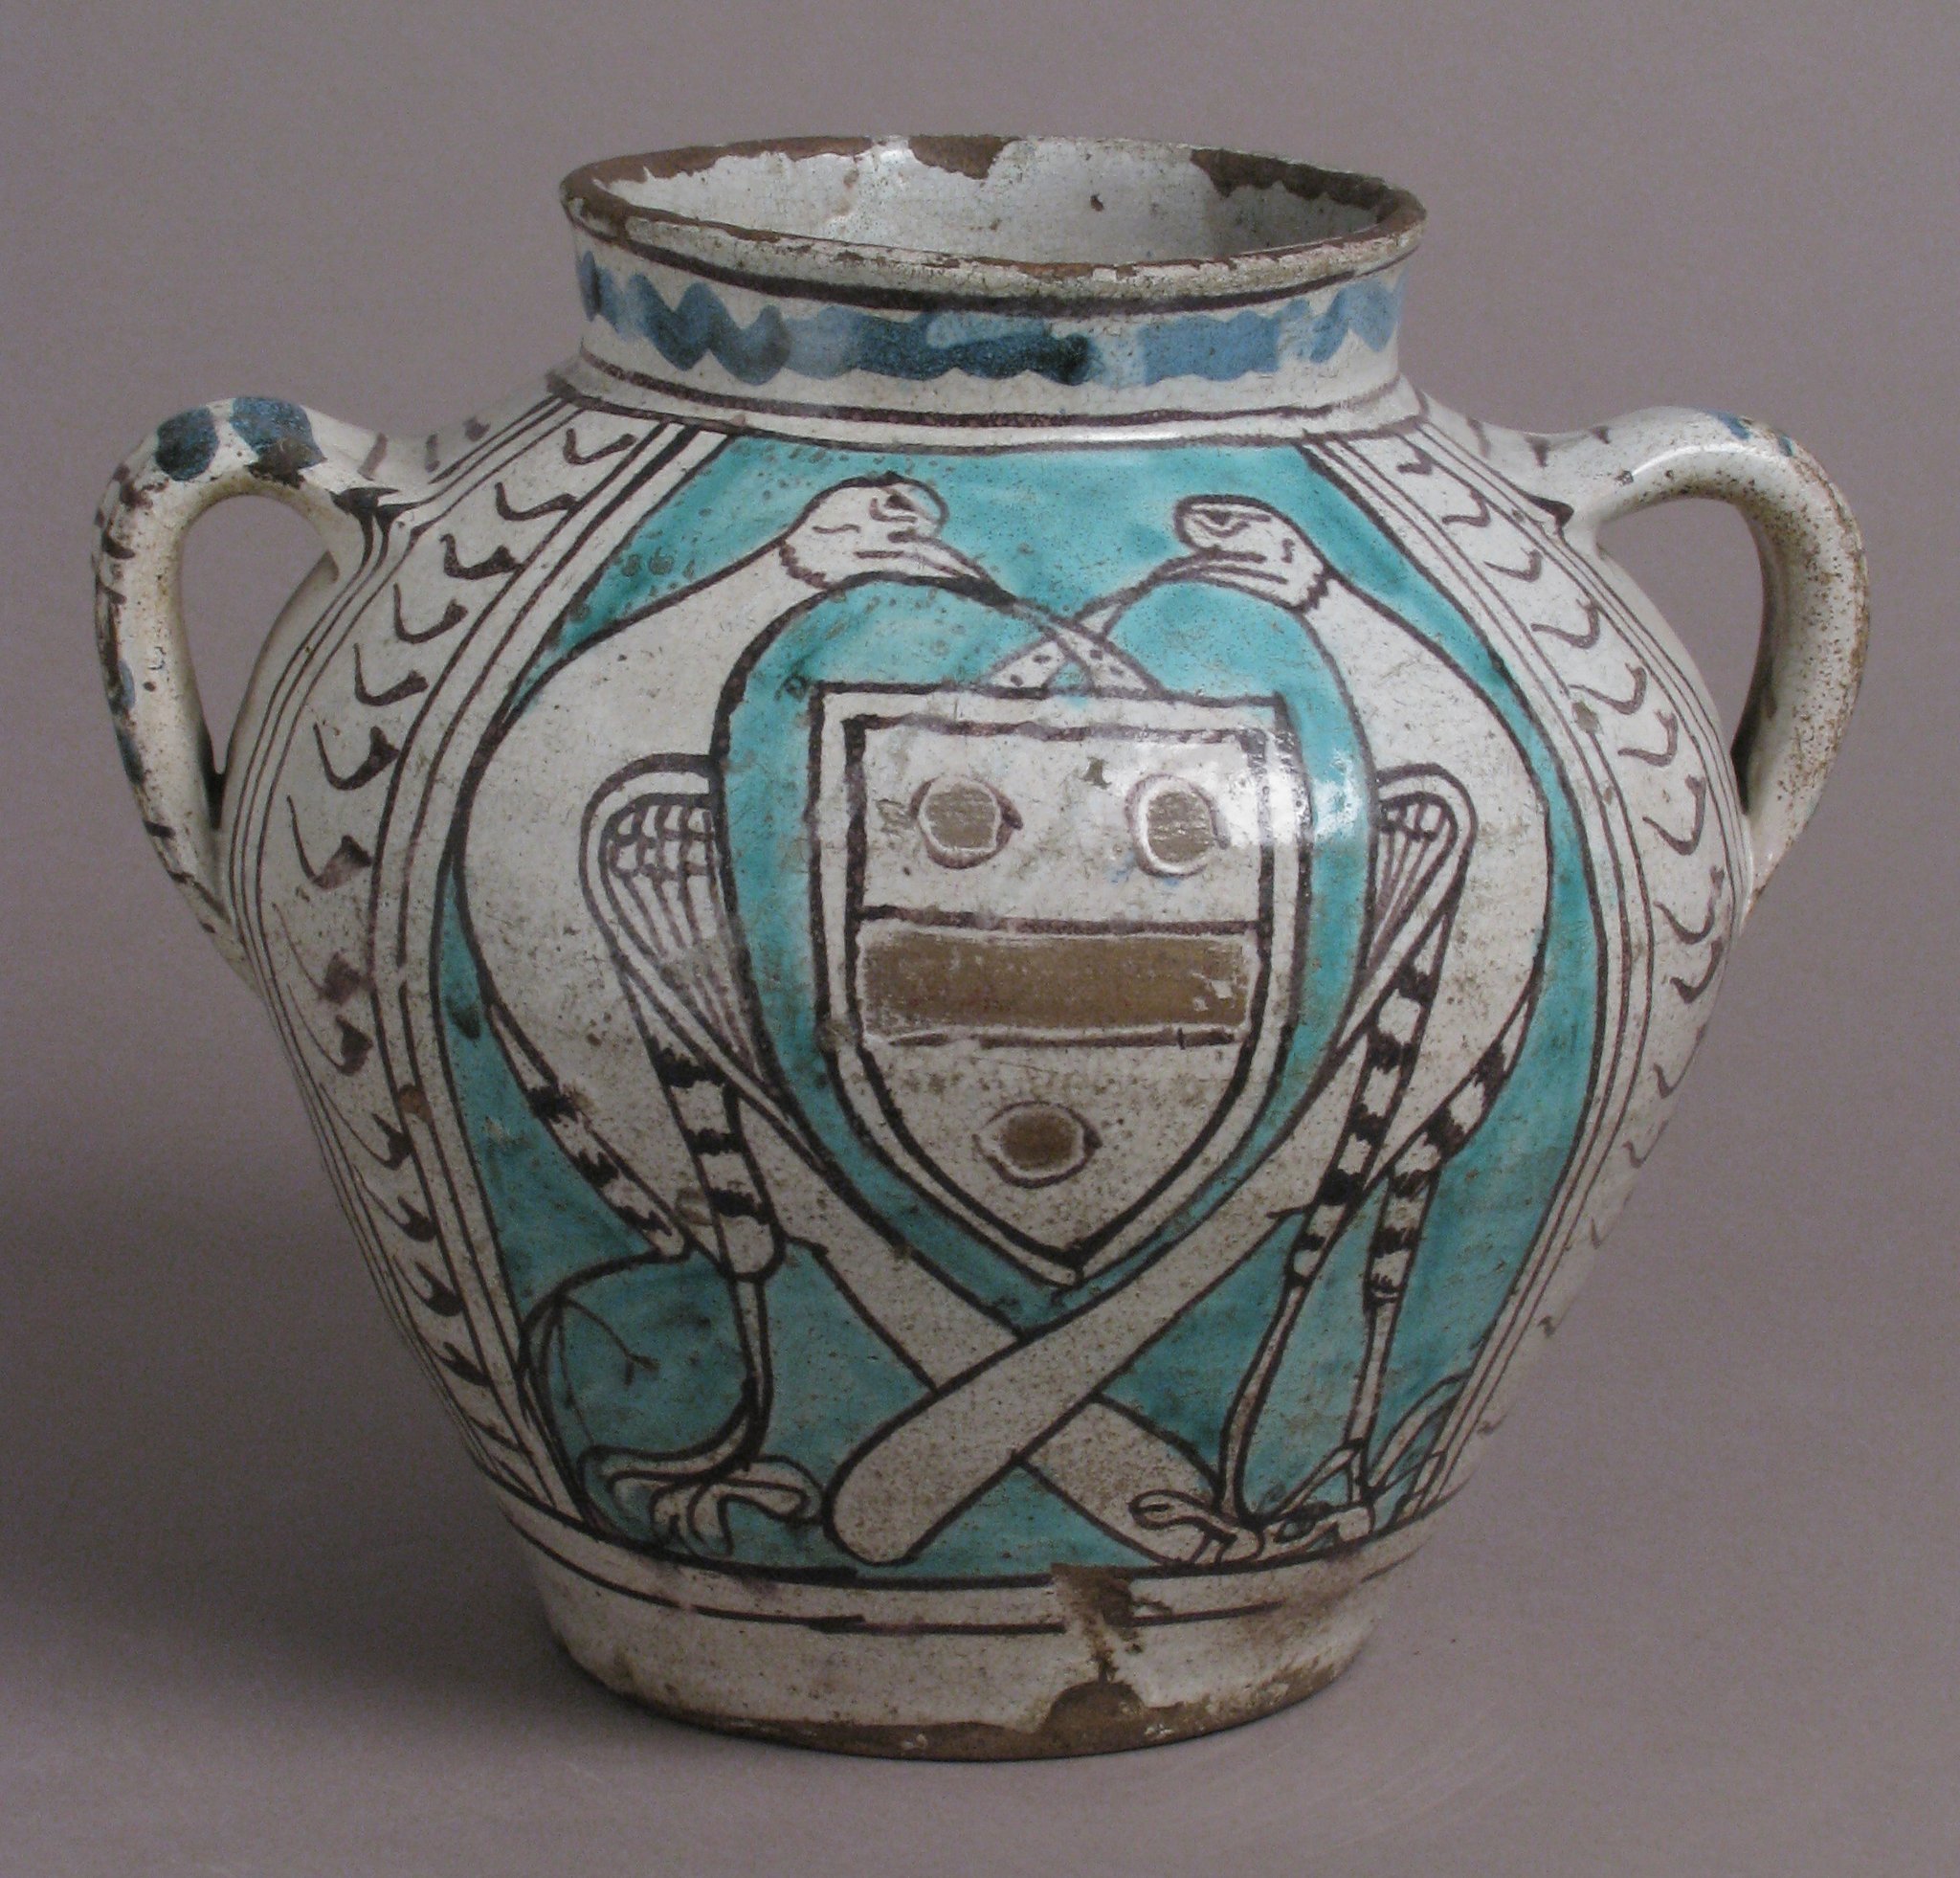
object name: jar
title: Two-Handled Jar with Birds and a Coat of Arms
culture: italian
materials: earthenware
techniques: glazing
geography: italy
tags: birds,coat of arms